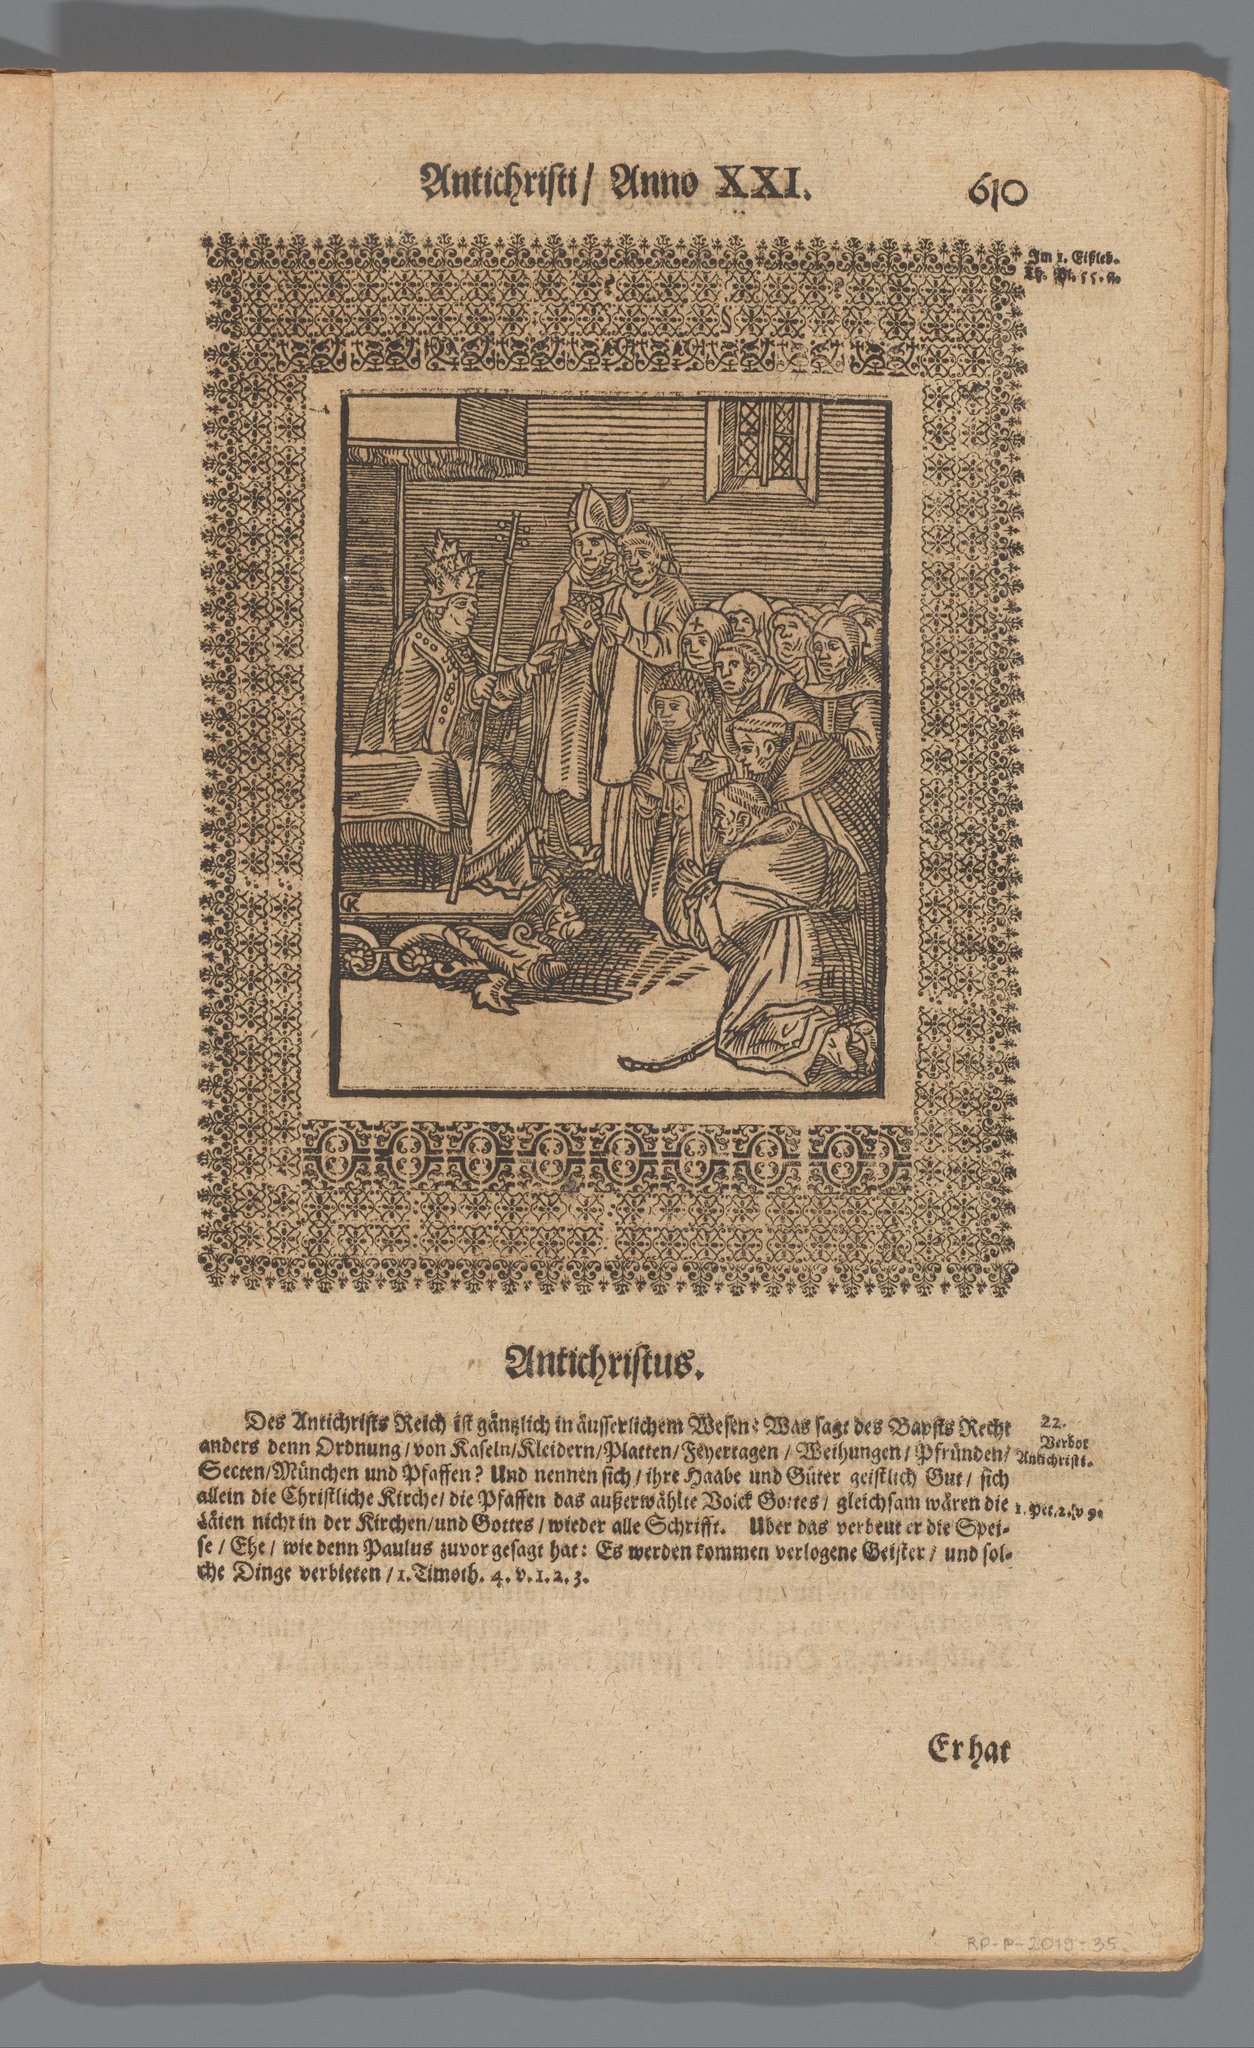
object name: print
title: Passional Christi und Antichristi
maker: monogrammist gk (prentmaker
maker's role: print maker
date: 1661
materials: paper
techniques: letterpress printing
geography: europe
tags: the richness of the church opposed to christ's humility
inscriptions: collector's mark: Lugt 2228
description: Het koninkrijk van de paus is van deze wereld: de paus zegent monniken en nonnen. Tegenstelling over de leer. Spiegelbeeldige kopie naar de prent van Lucas Cranach in het pamflet 'Passional Christi und Antichristi' van Martin Luther uit 1521, bladzijde 610 uit een 17e-eeuwse uitgave. De reeks van dertien paar houtsneden geeft de tegenstellingen weer tussen de nederigheid en onbaatzuchtigheid van Christus enerzijds, en de trots en hebzucht van de paus anderzijds.